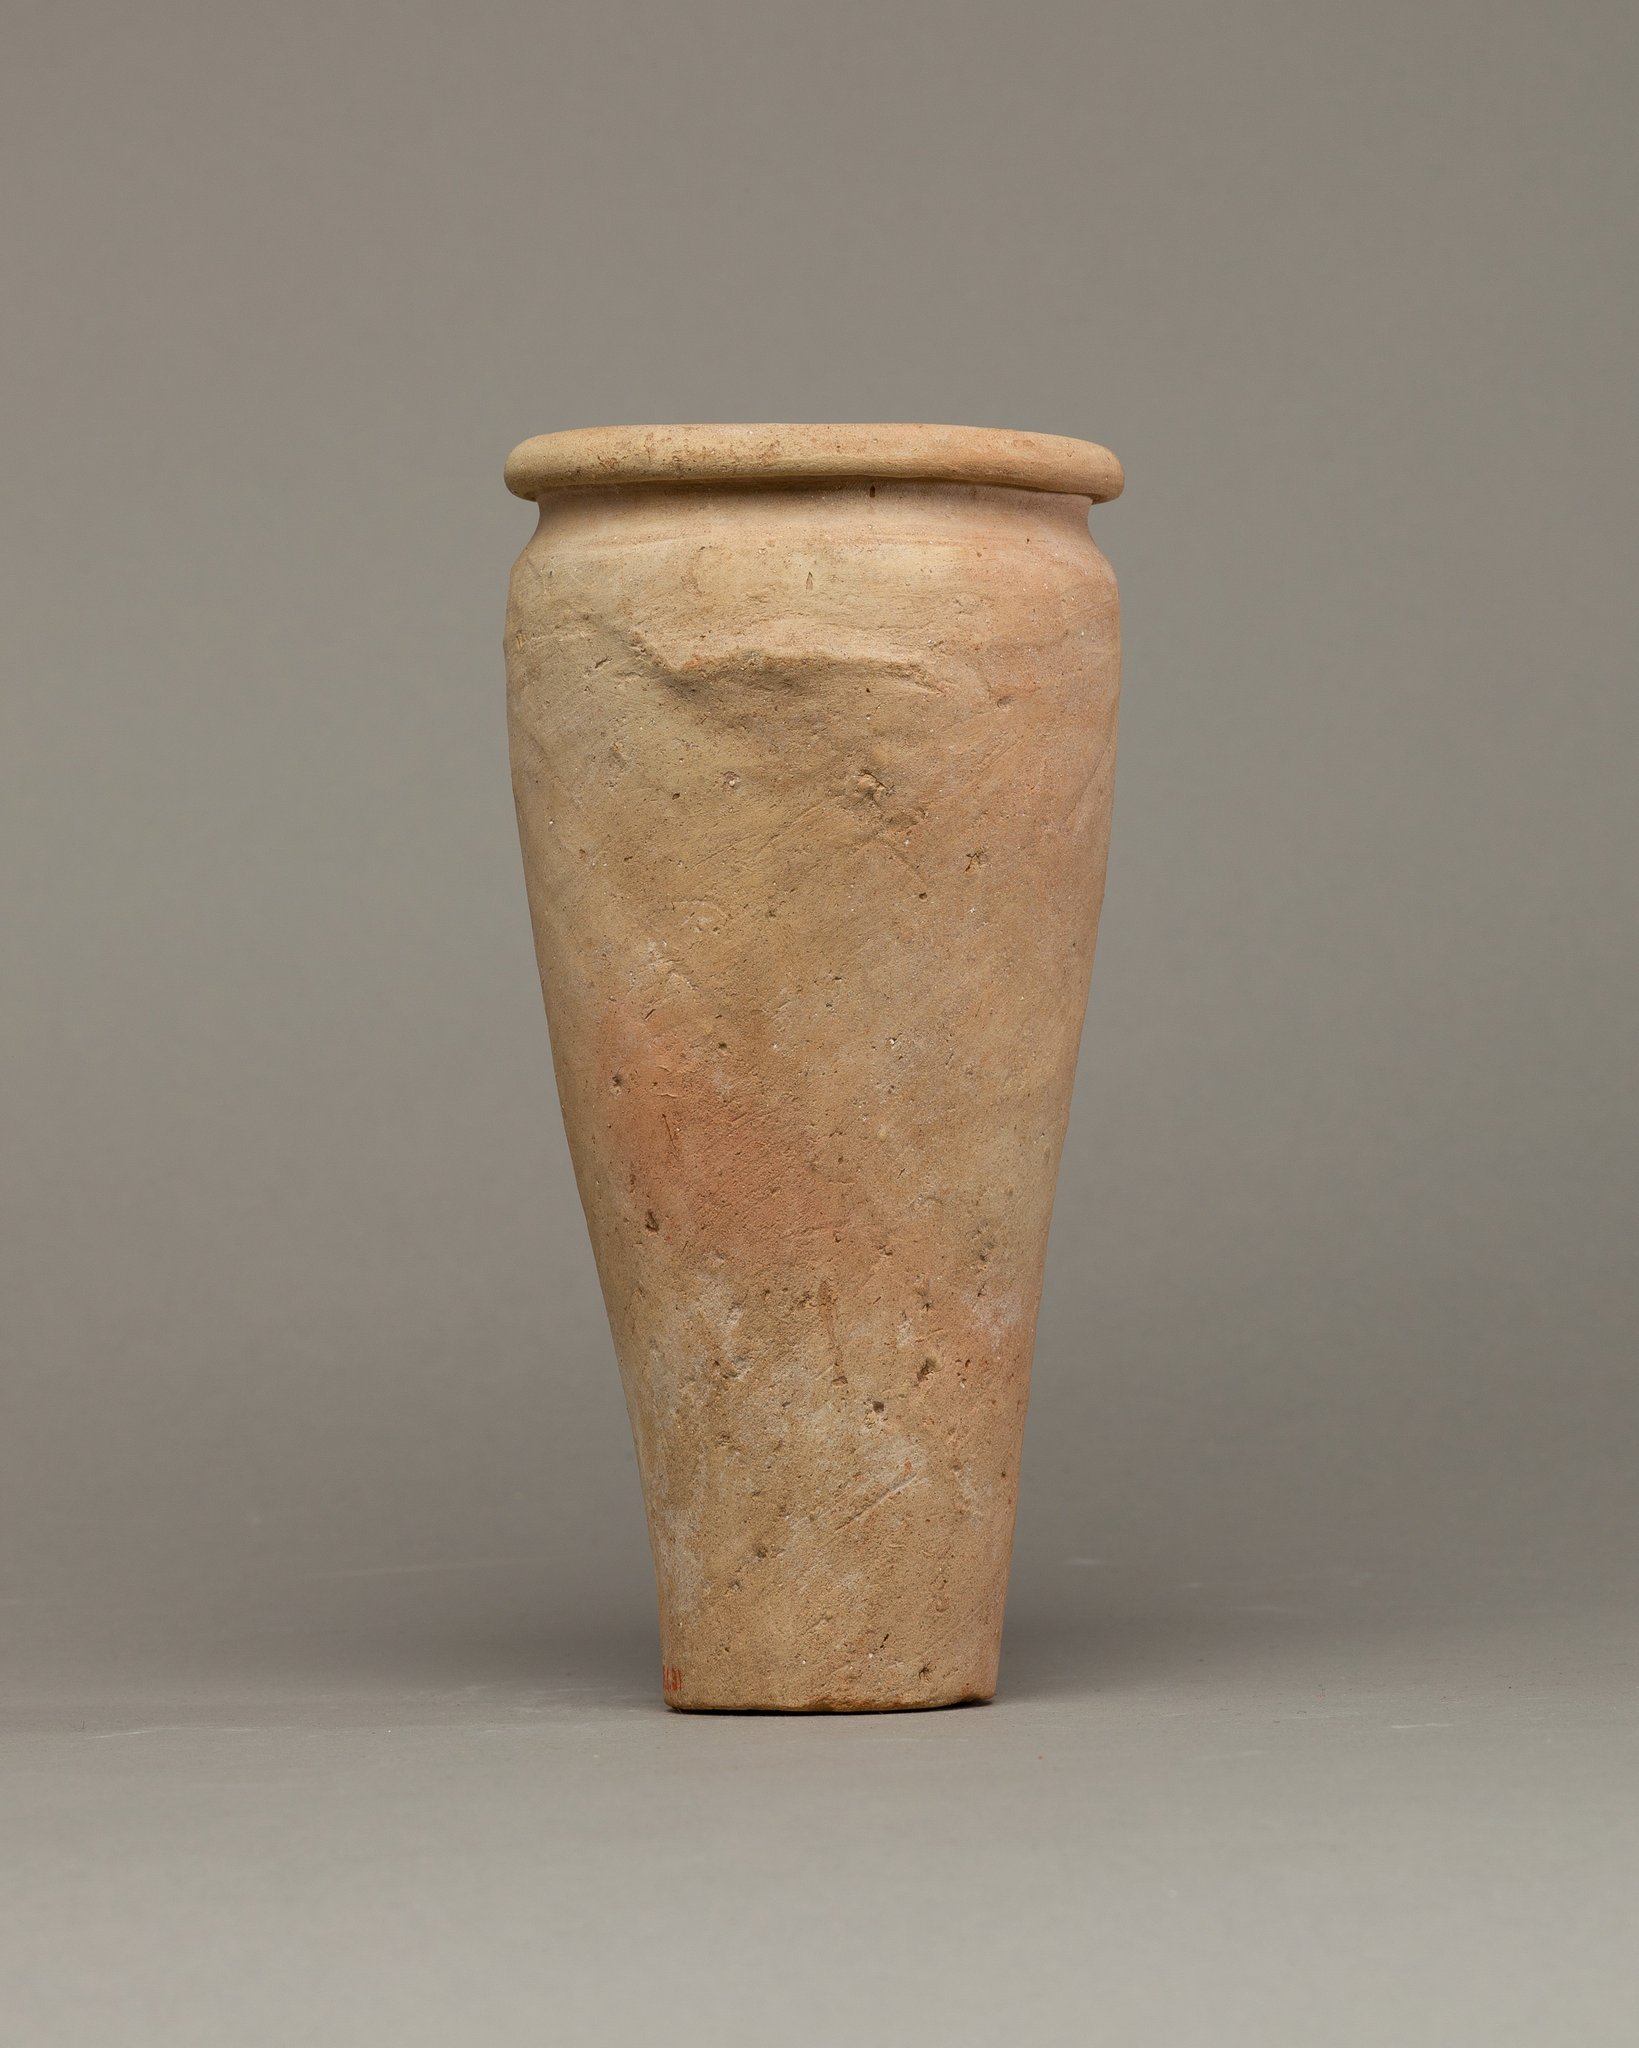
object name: jar, cylinder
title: Wavy-handled jar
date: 3850-2960 BCE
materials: pottery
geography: egypt